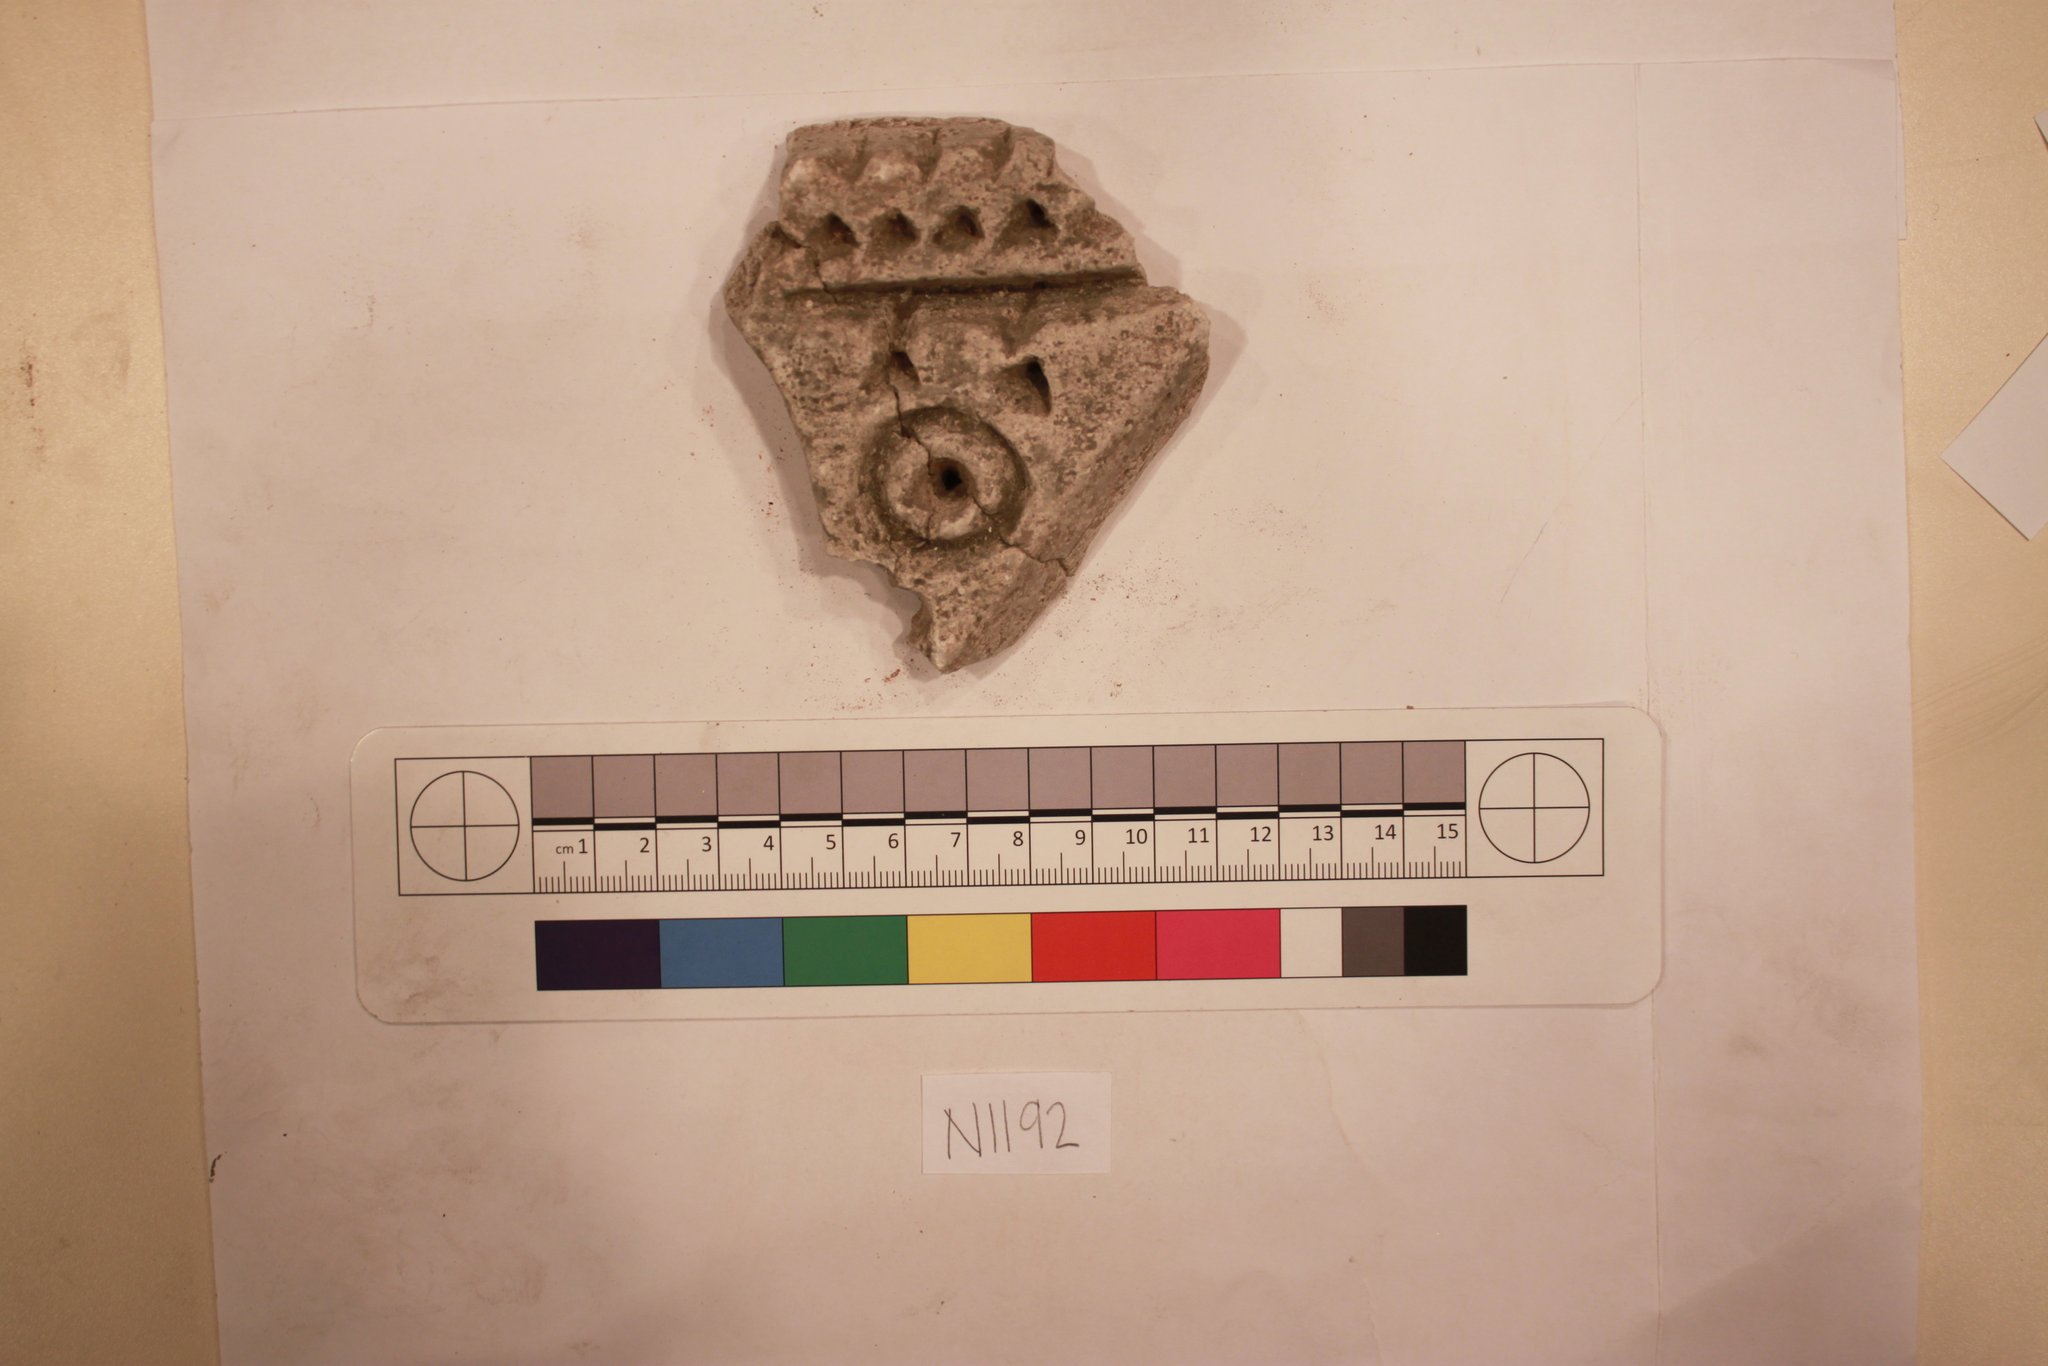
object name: fragment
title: Stucco Fragment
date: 701-1200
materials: plaster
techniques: carving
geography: iran